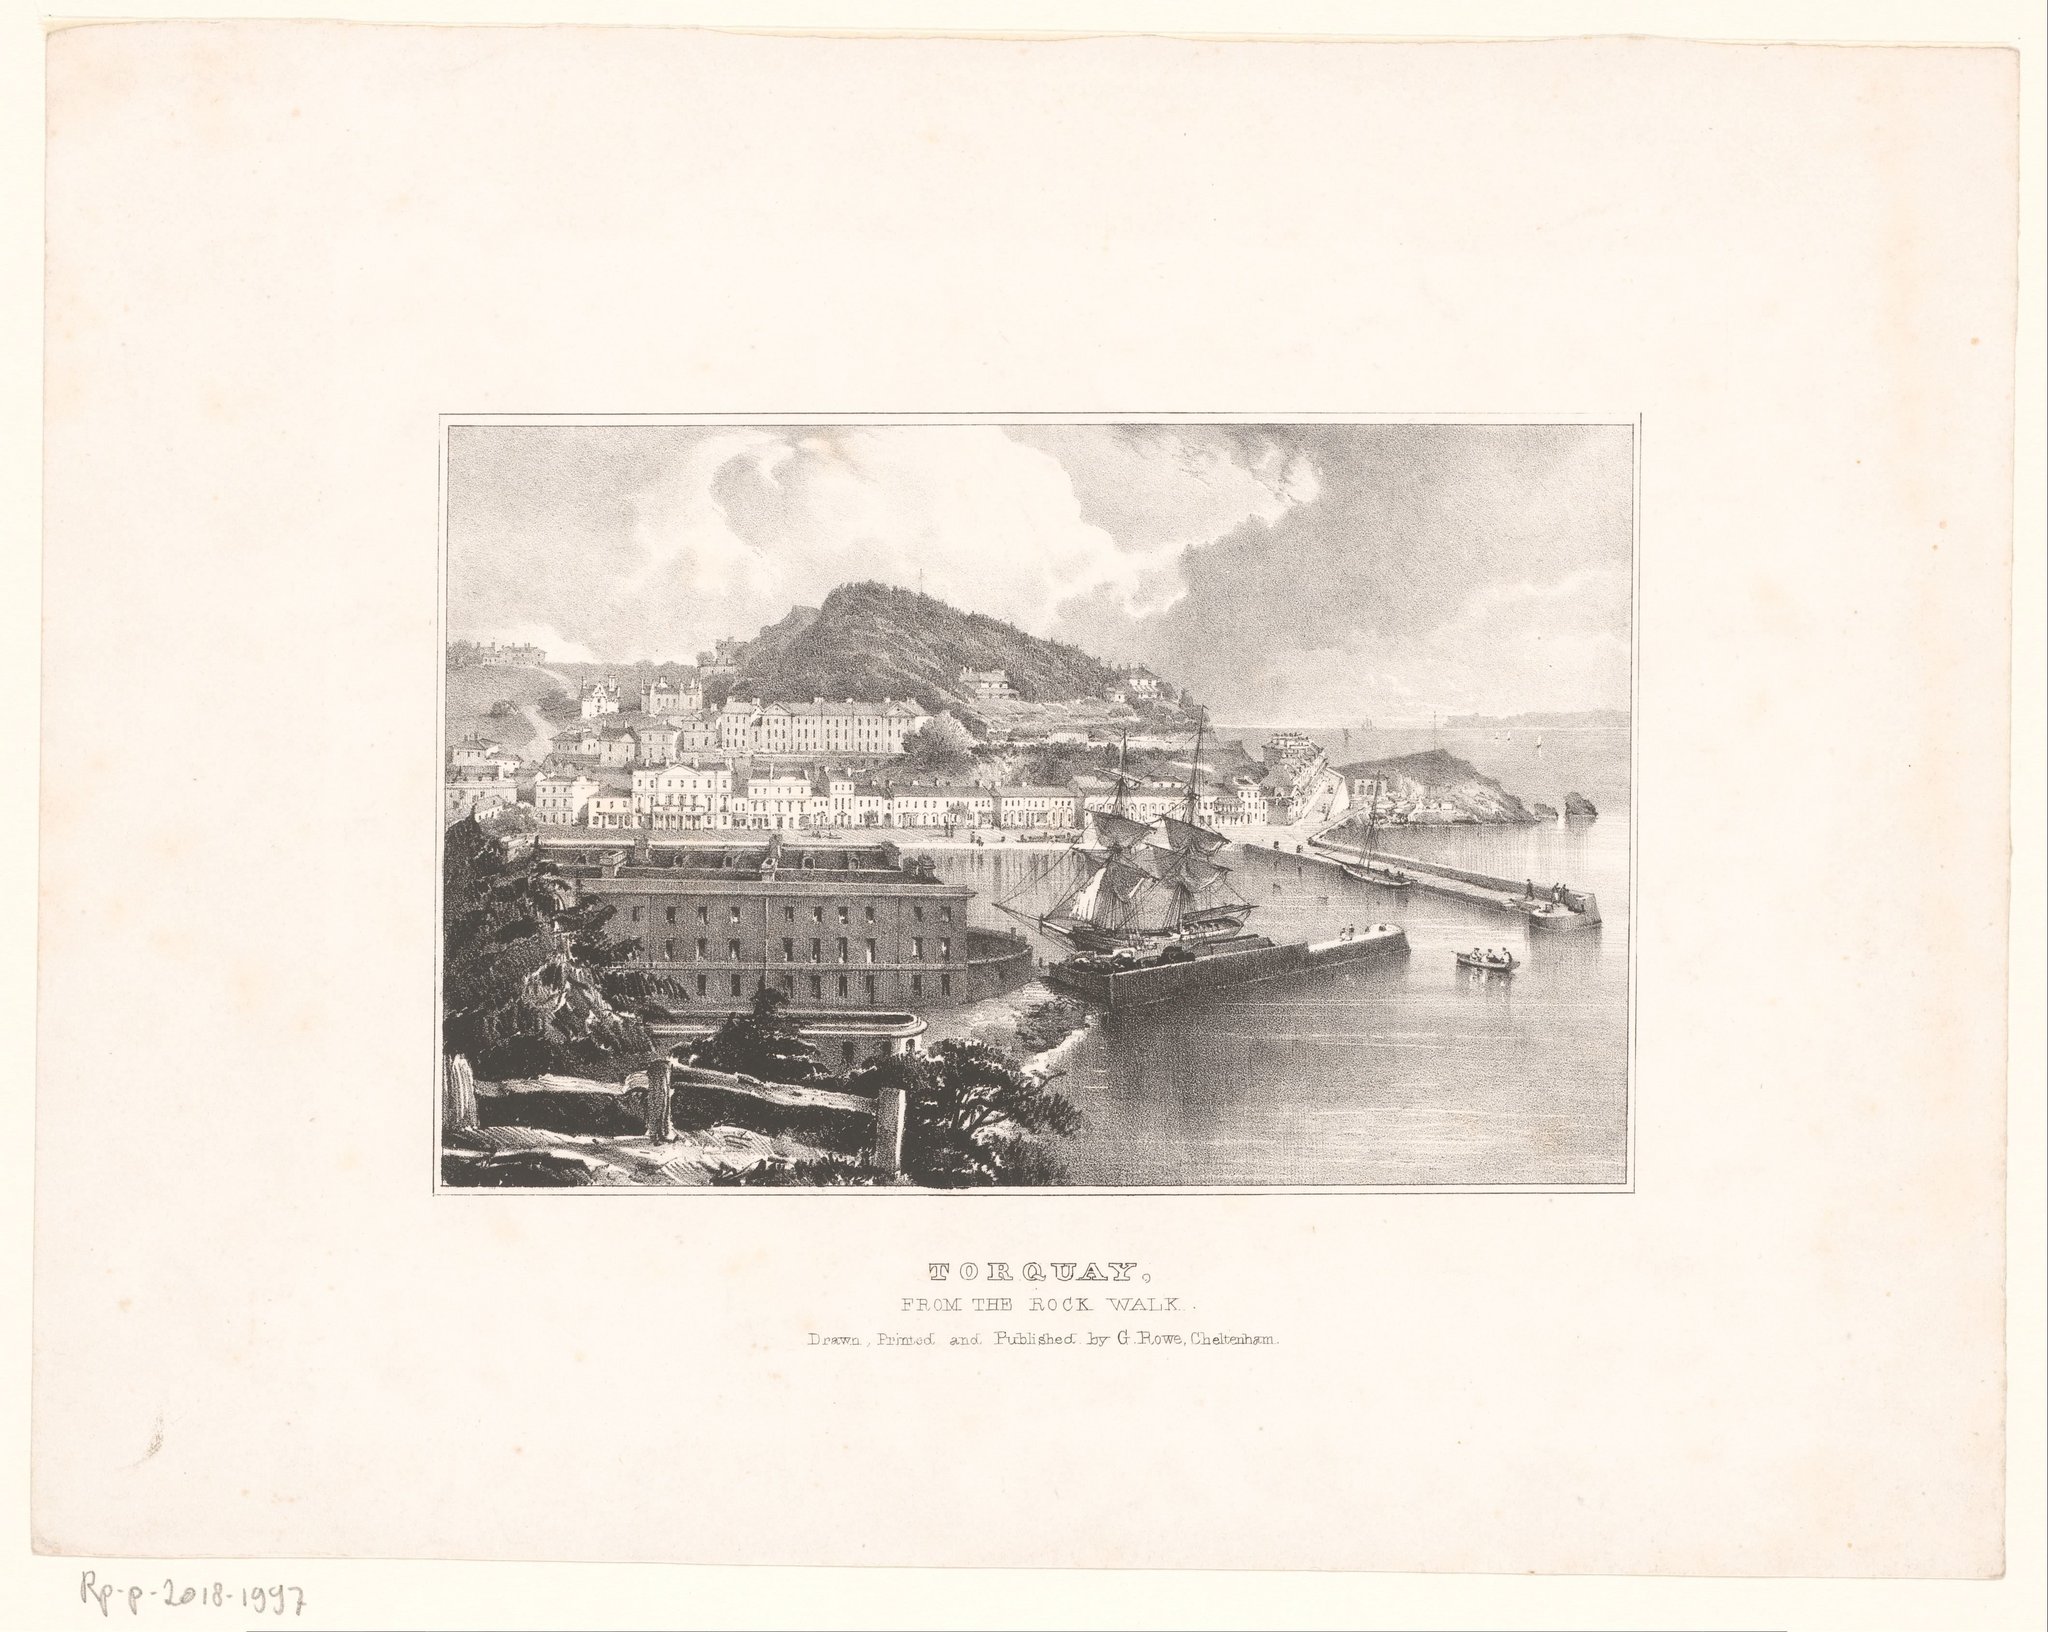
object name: print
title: Gezicht op Torquay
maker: george rowe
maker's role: print maker, printer, publisher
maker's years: 1796-1864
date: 1832-1852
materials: paper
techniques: lithograph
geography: cheltenham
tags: prospect of city, town panorama, silhouette of city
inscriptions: collector's mark: Lugt 2228